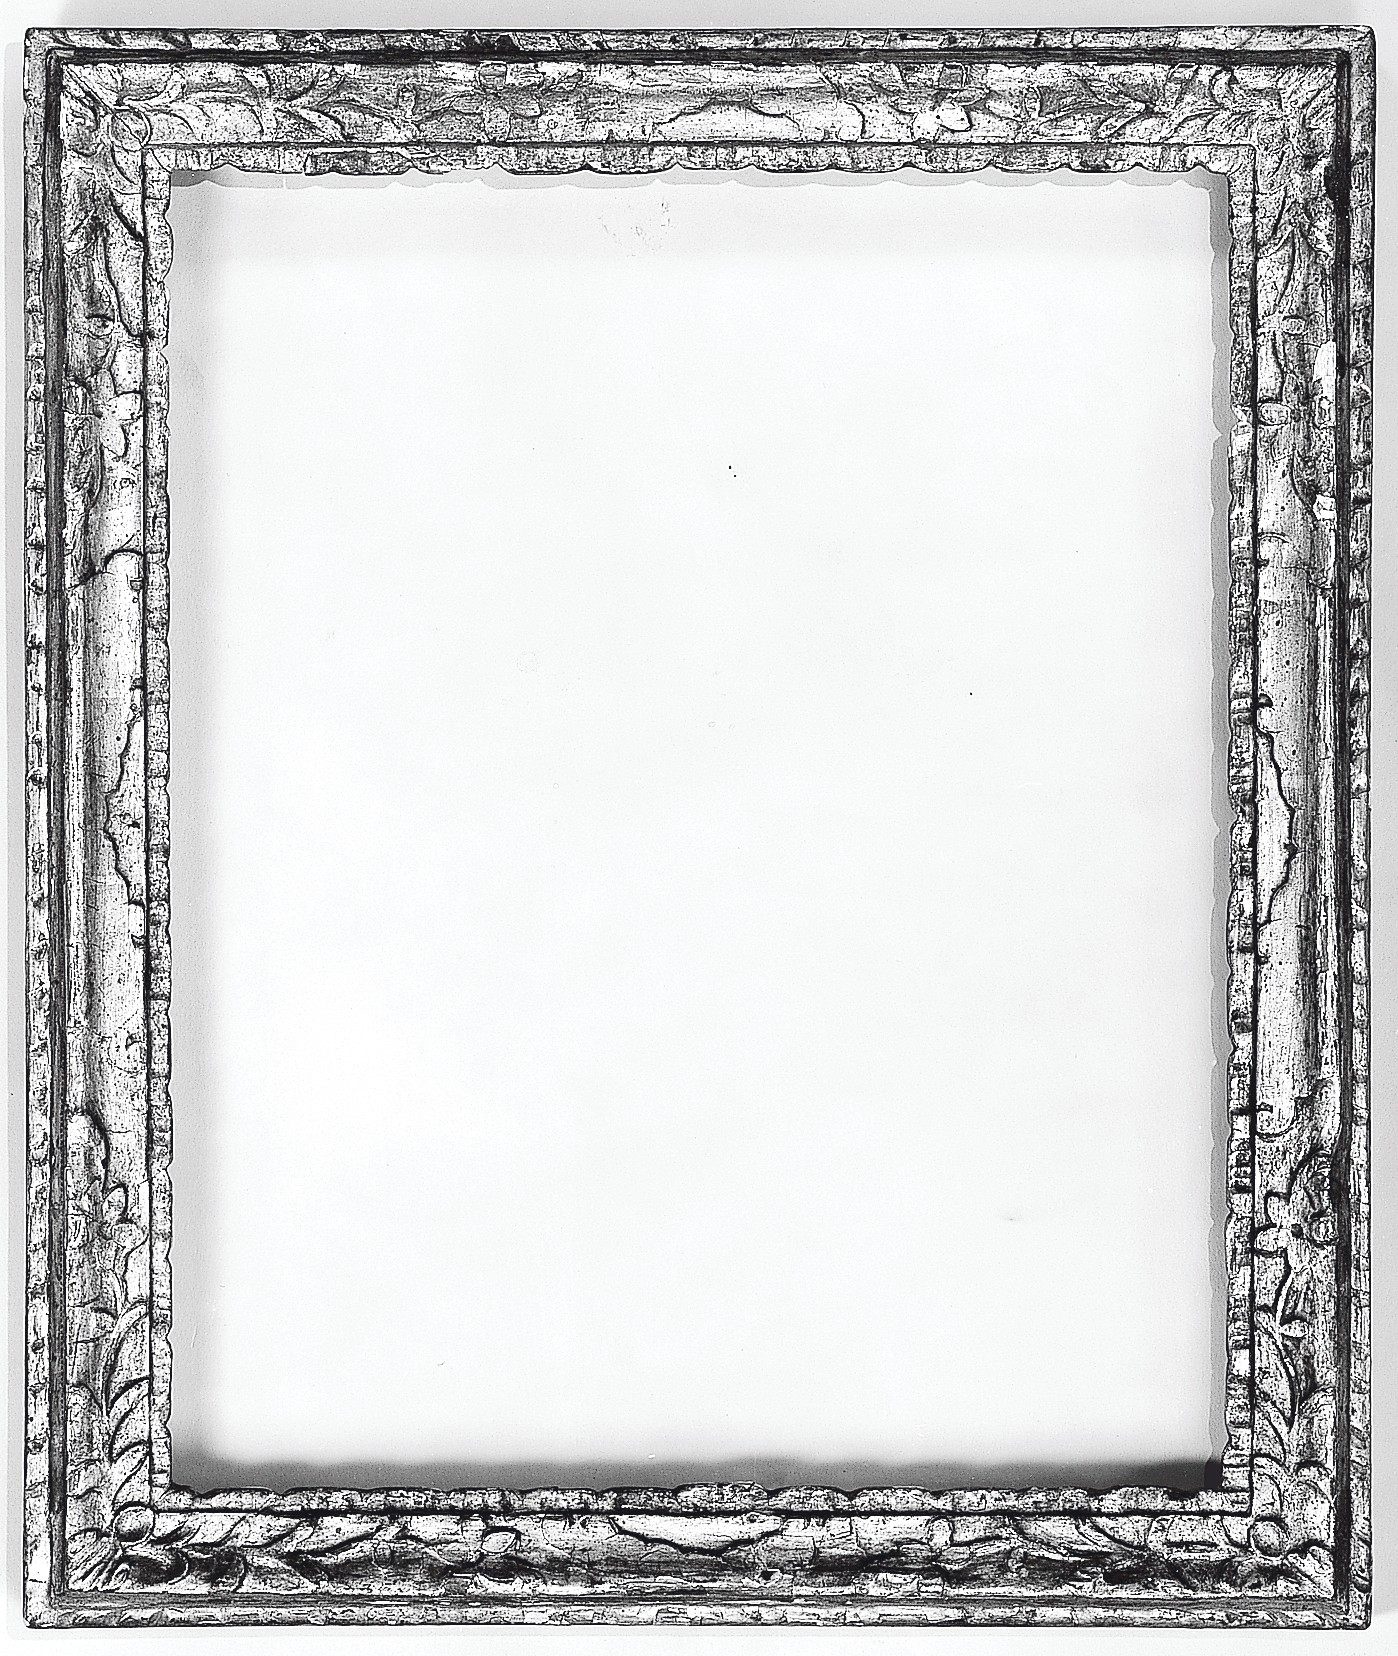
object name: frame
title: Canaletto-style mirror frame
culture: italian, veneto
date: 1734-1766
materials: wood